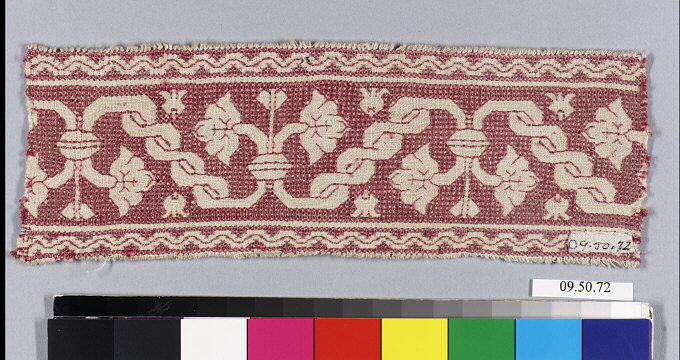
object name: border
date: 1501-1700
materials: linen, silk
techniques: embroidery